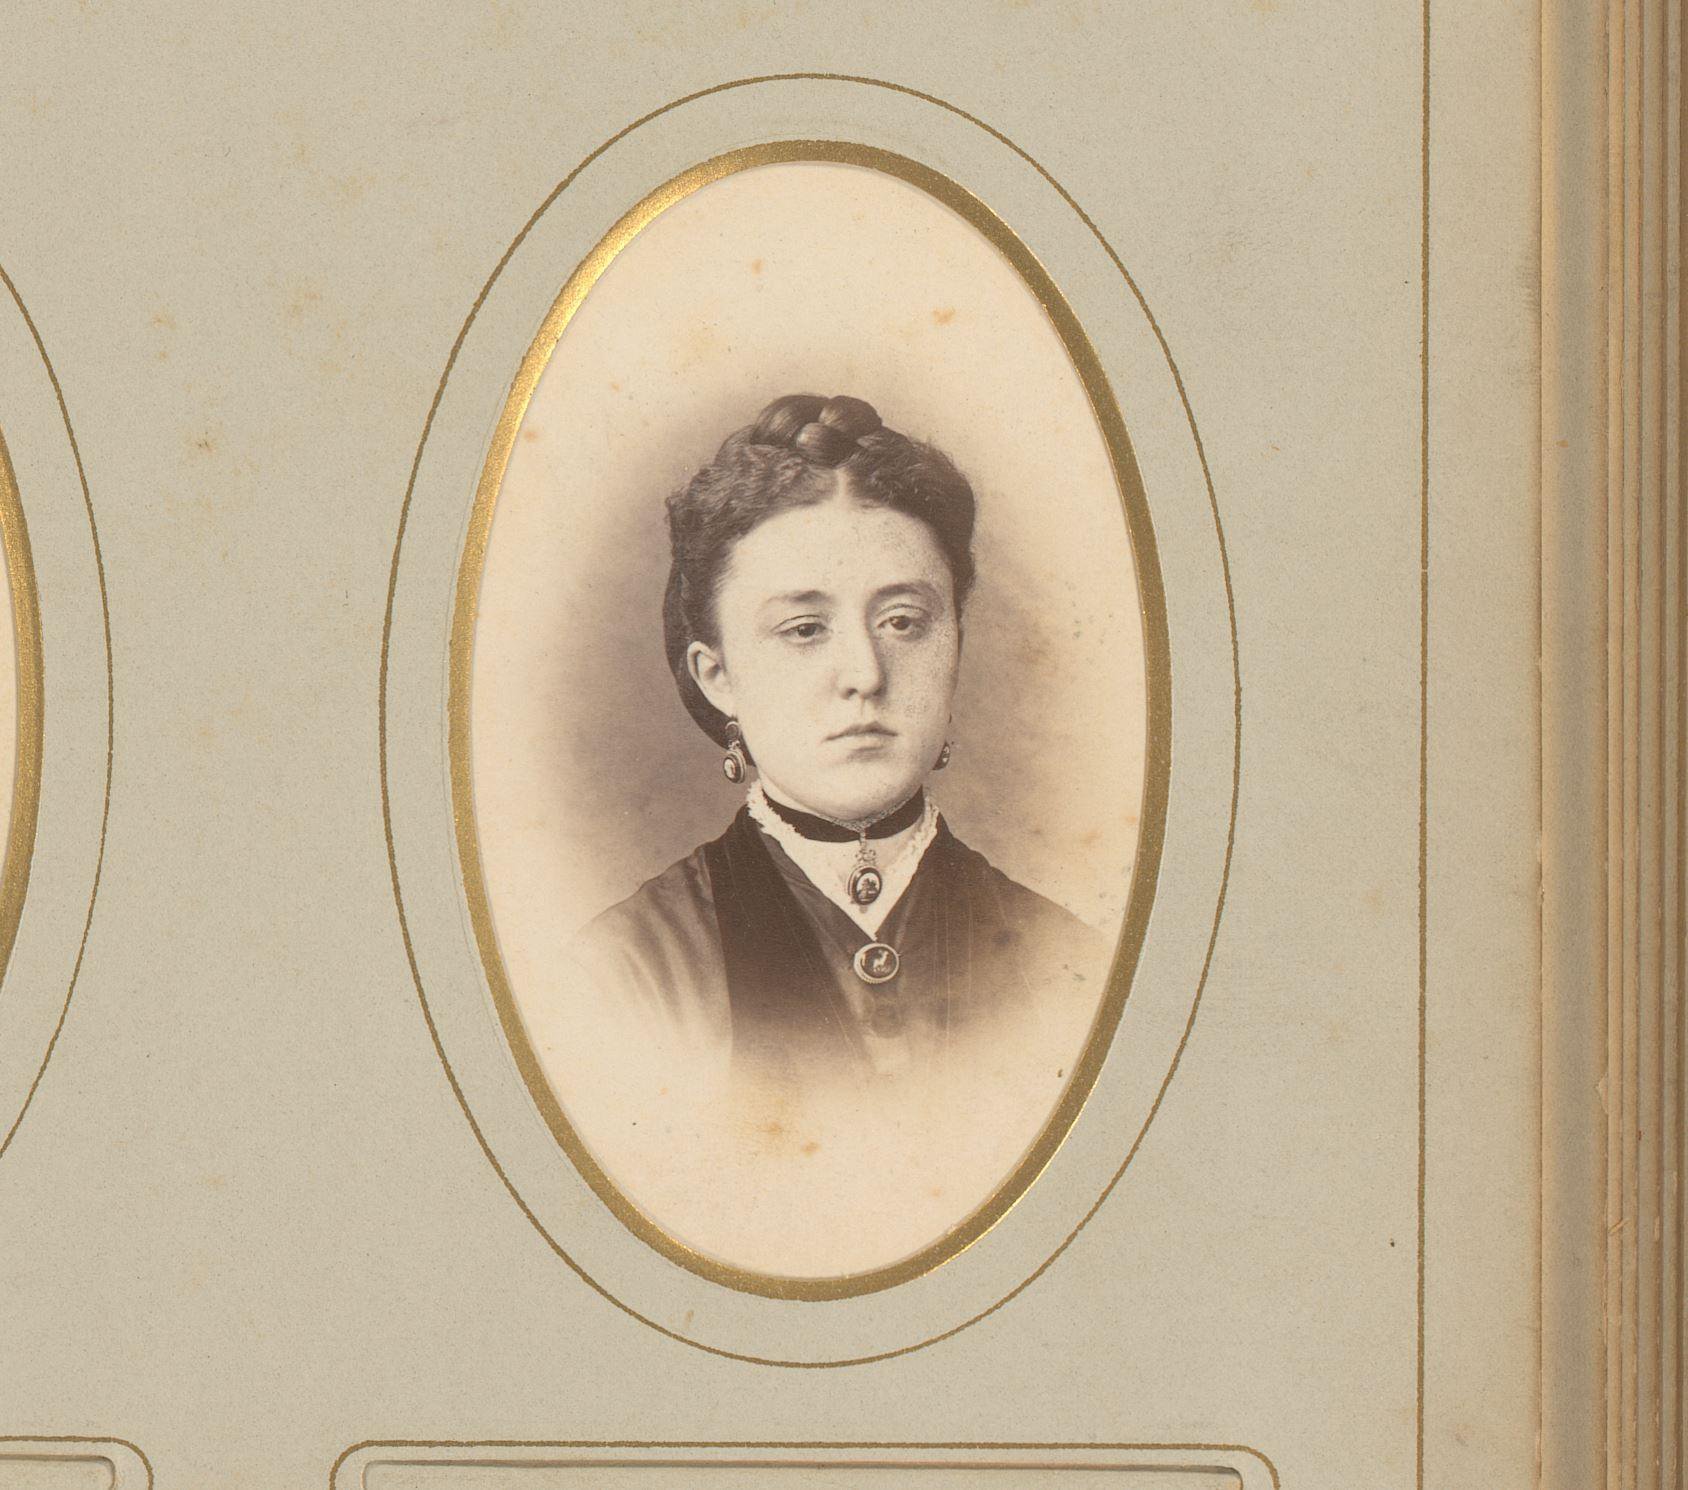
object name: album leaf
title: Portret van een vrouw met halsketting en vlecht in het haar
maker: palmer descamps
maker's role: goldsmith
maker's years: 1840-1884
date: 1865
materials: cardboard, photographic support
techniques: albumen print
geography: kortrijk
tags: historical persons - bb - woman, hairdress, necklace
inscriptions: inscription: ‘COURTRAI/ RUE DE LA LYS, 13./ PHOTOGRAPHIE/ Descamps/ PALMER/ ORFÈVRERIE’